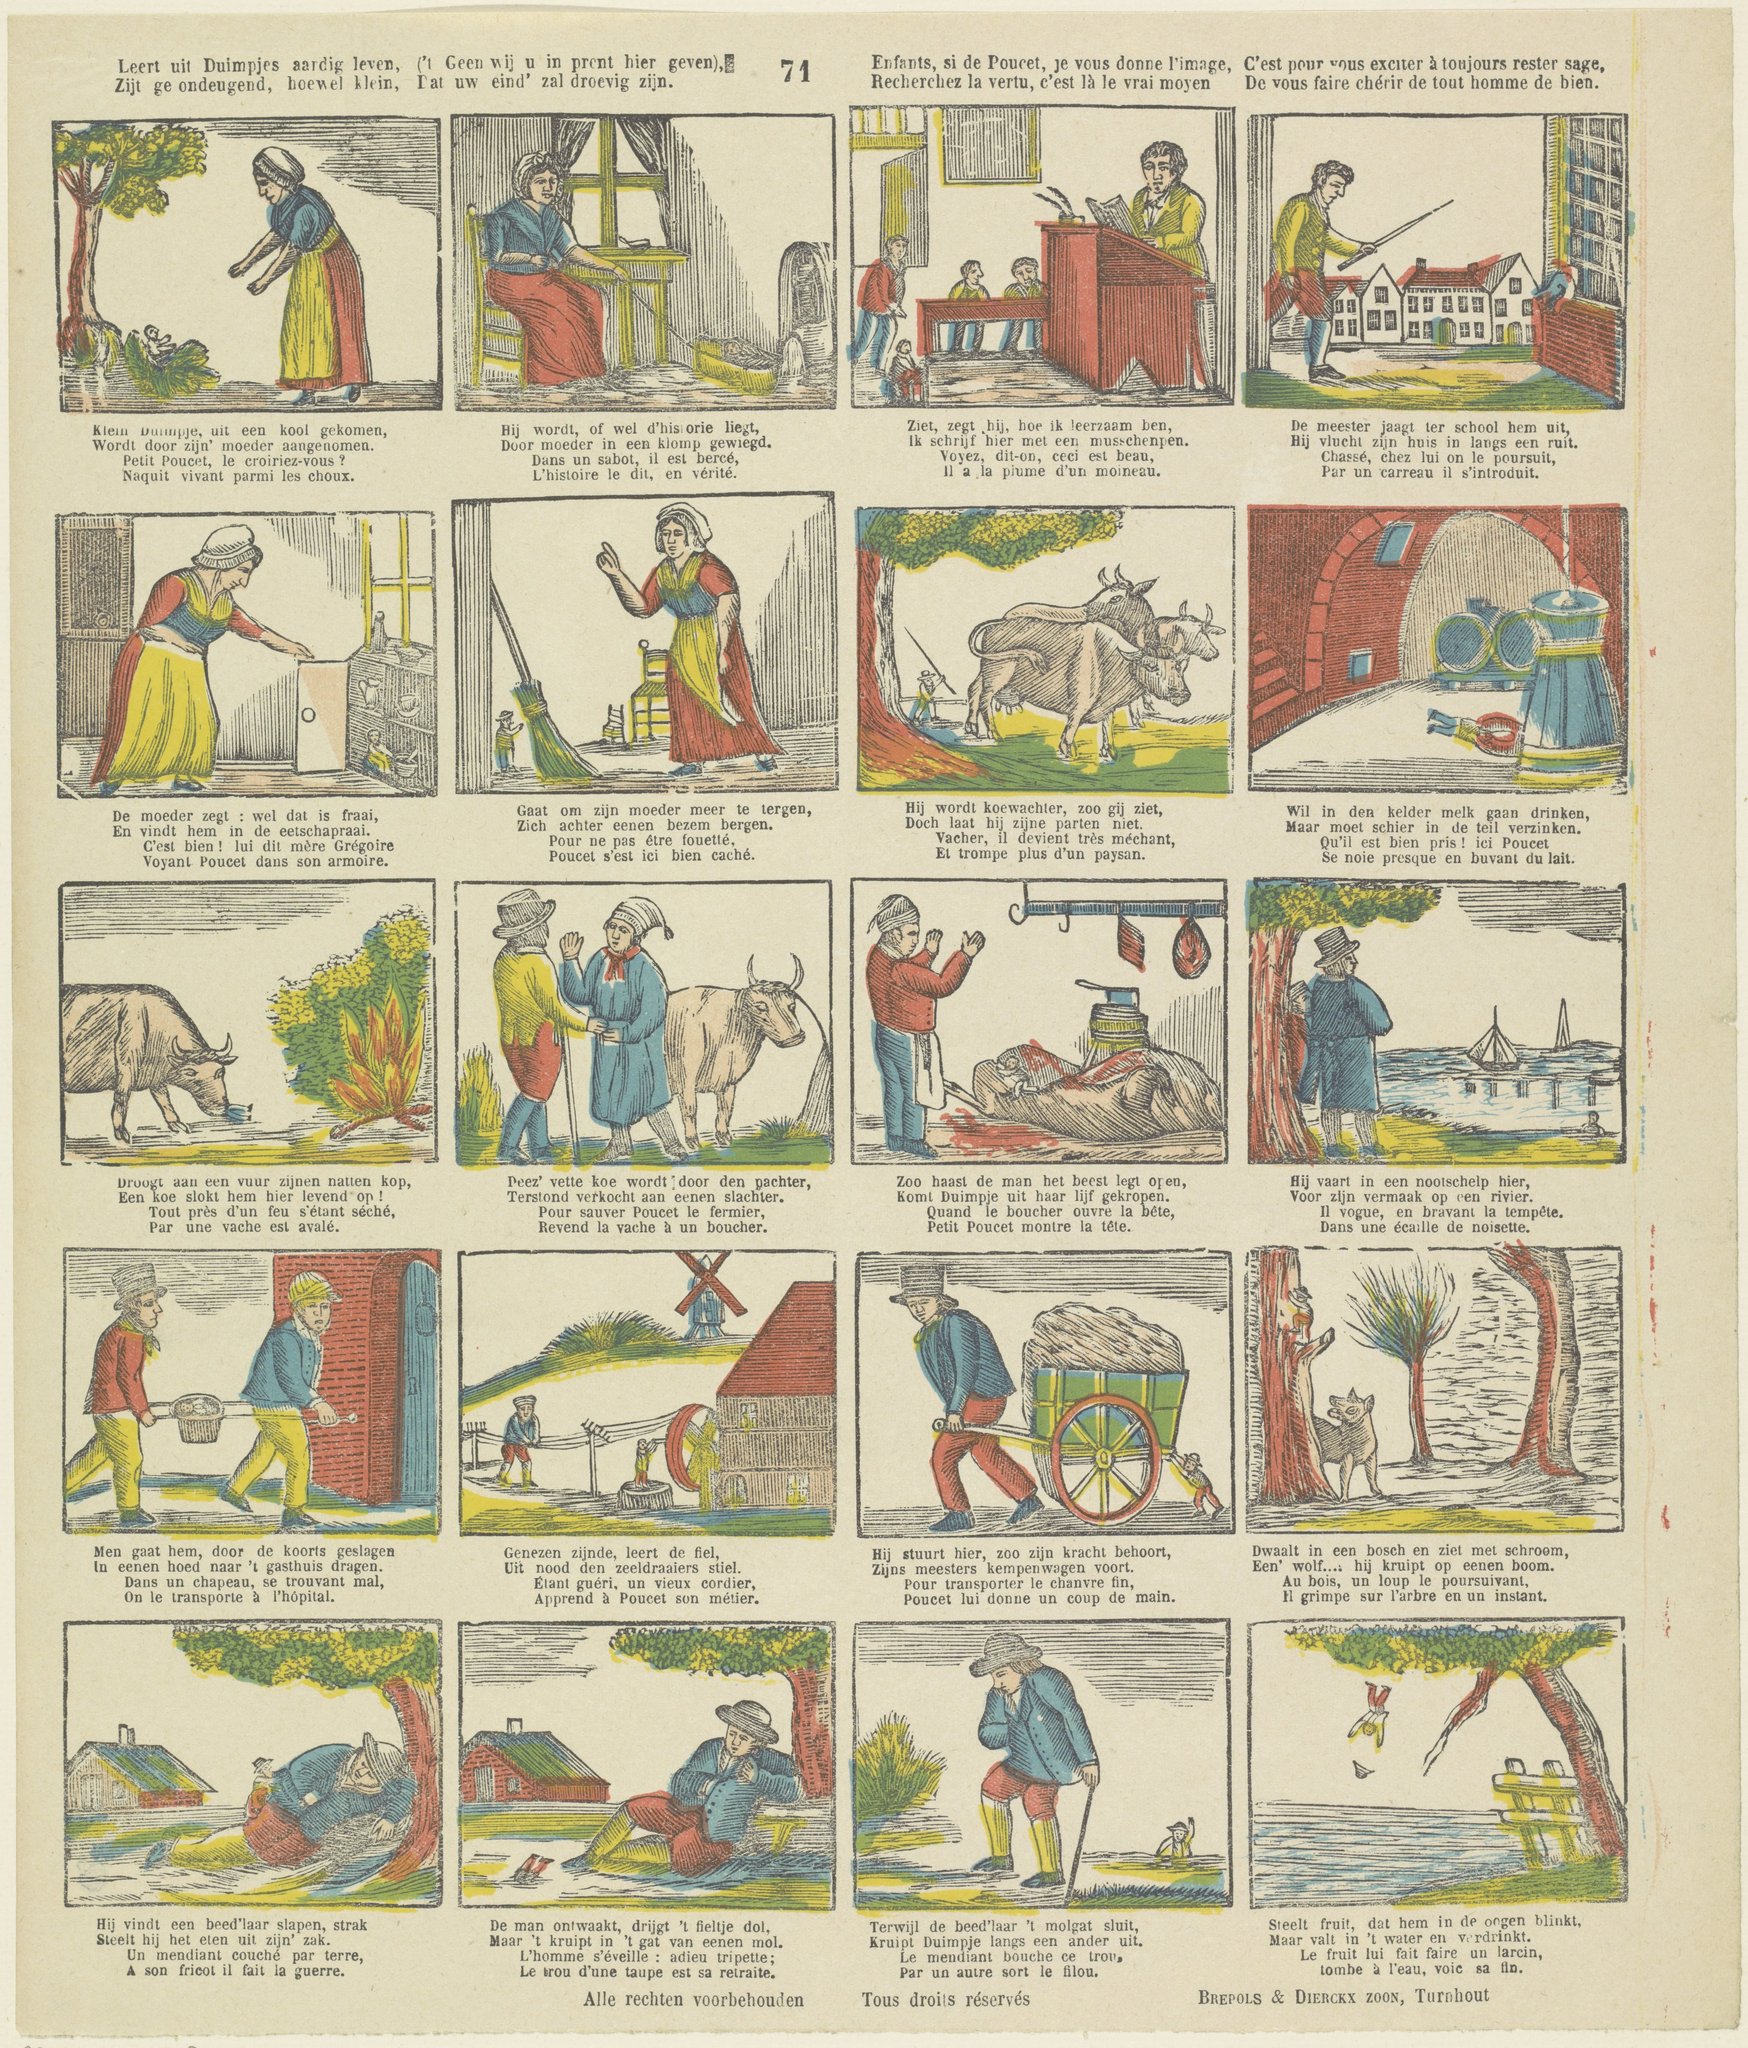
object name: popular print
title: Leert uit Duimpjes aardig leven, ('t geen wij u in prent hier geven : ) / Zijt g'ondeugend, hoewel klein, dat uw eind' zal droevig zijn / Enfants si de Poucet, je vous donne l'image, c'est pour vous exciter à toujours rester sage; / Recherchez la vertu, c'est là le vrai moyen de vous faire chérir de tout homme de bien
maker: Anonymous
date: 1833-1911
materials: paper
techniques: lithograph, letterpress printing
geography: turnhout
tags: tales and fairy tales, tales and fairy tales: little thumbling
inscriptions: collector's mark: Lugt 2760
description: Blad met 20 voorstellingen uit het verhaal van Klein Duimpje. Onder elke voorstelling een tweeregelig vers in het Nederlands en in het Frans. Genummerd midden boven: 71.